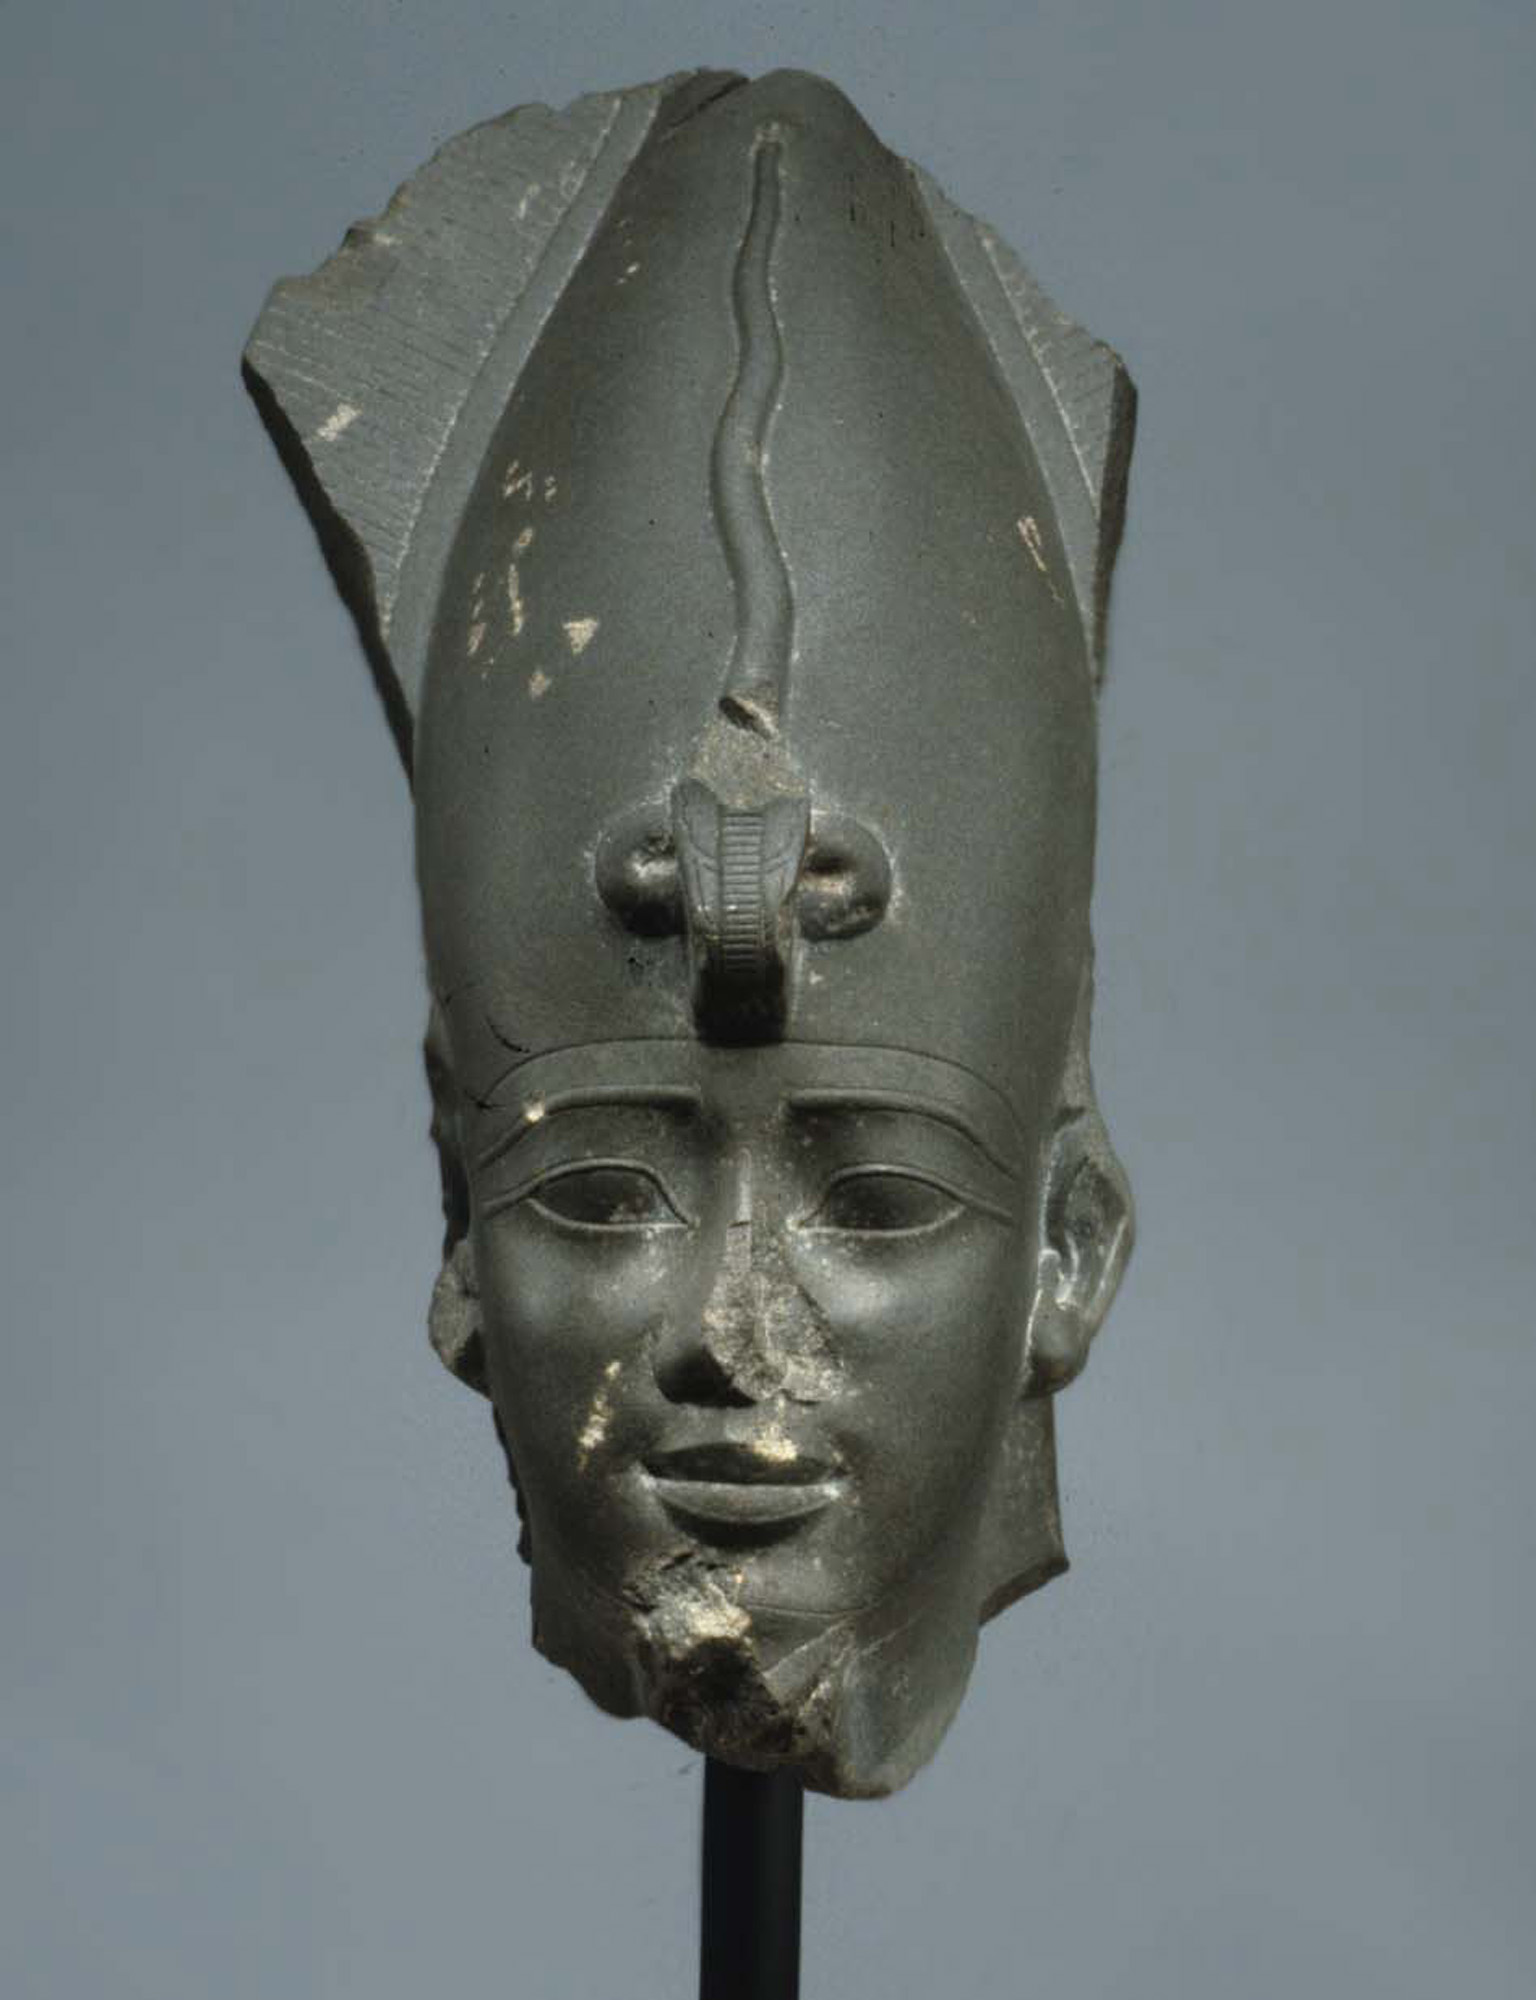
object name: head, osiris, atef crown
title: Head of Osiris wearing Atef Crown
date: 600-550 BCE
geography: egypt